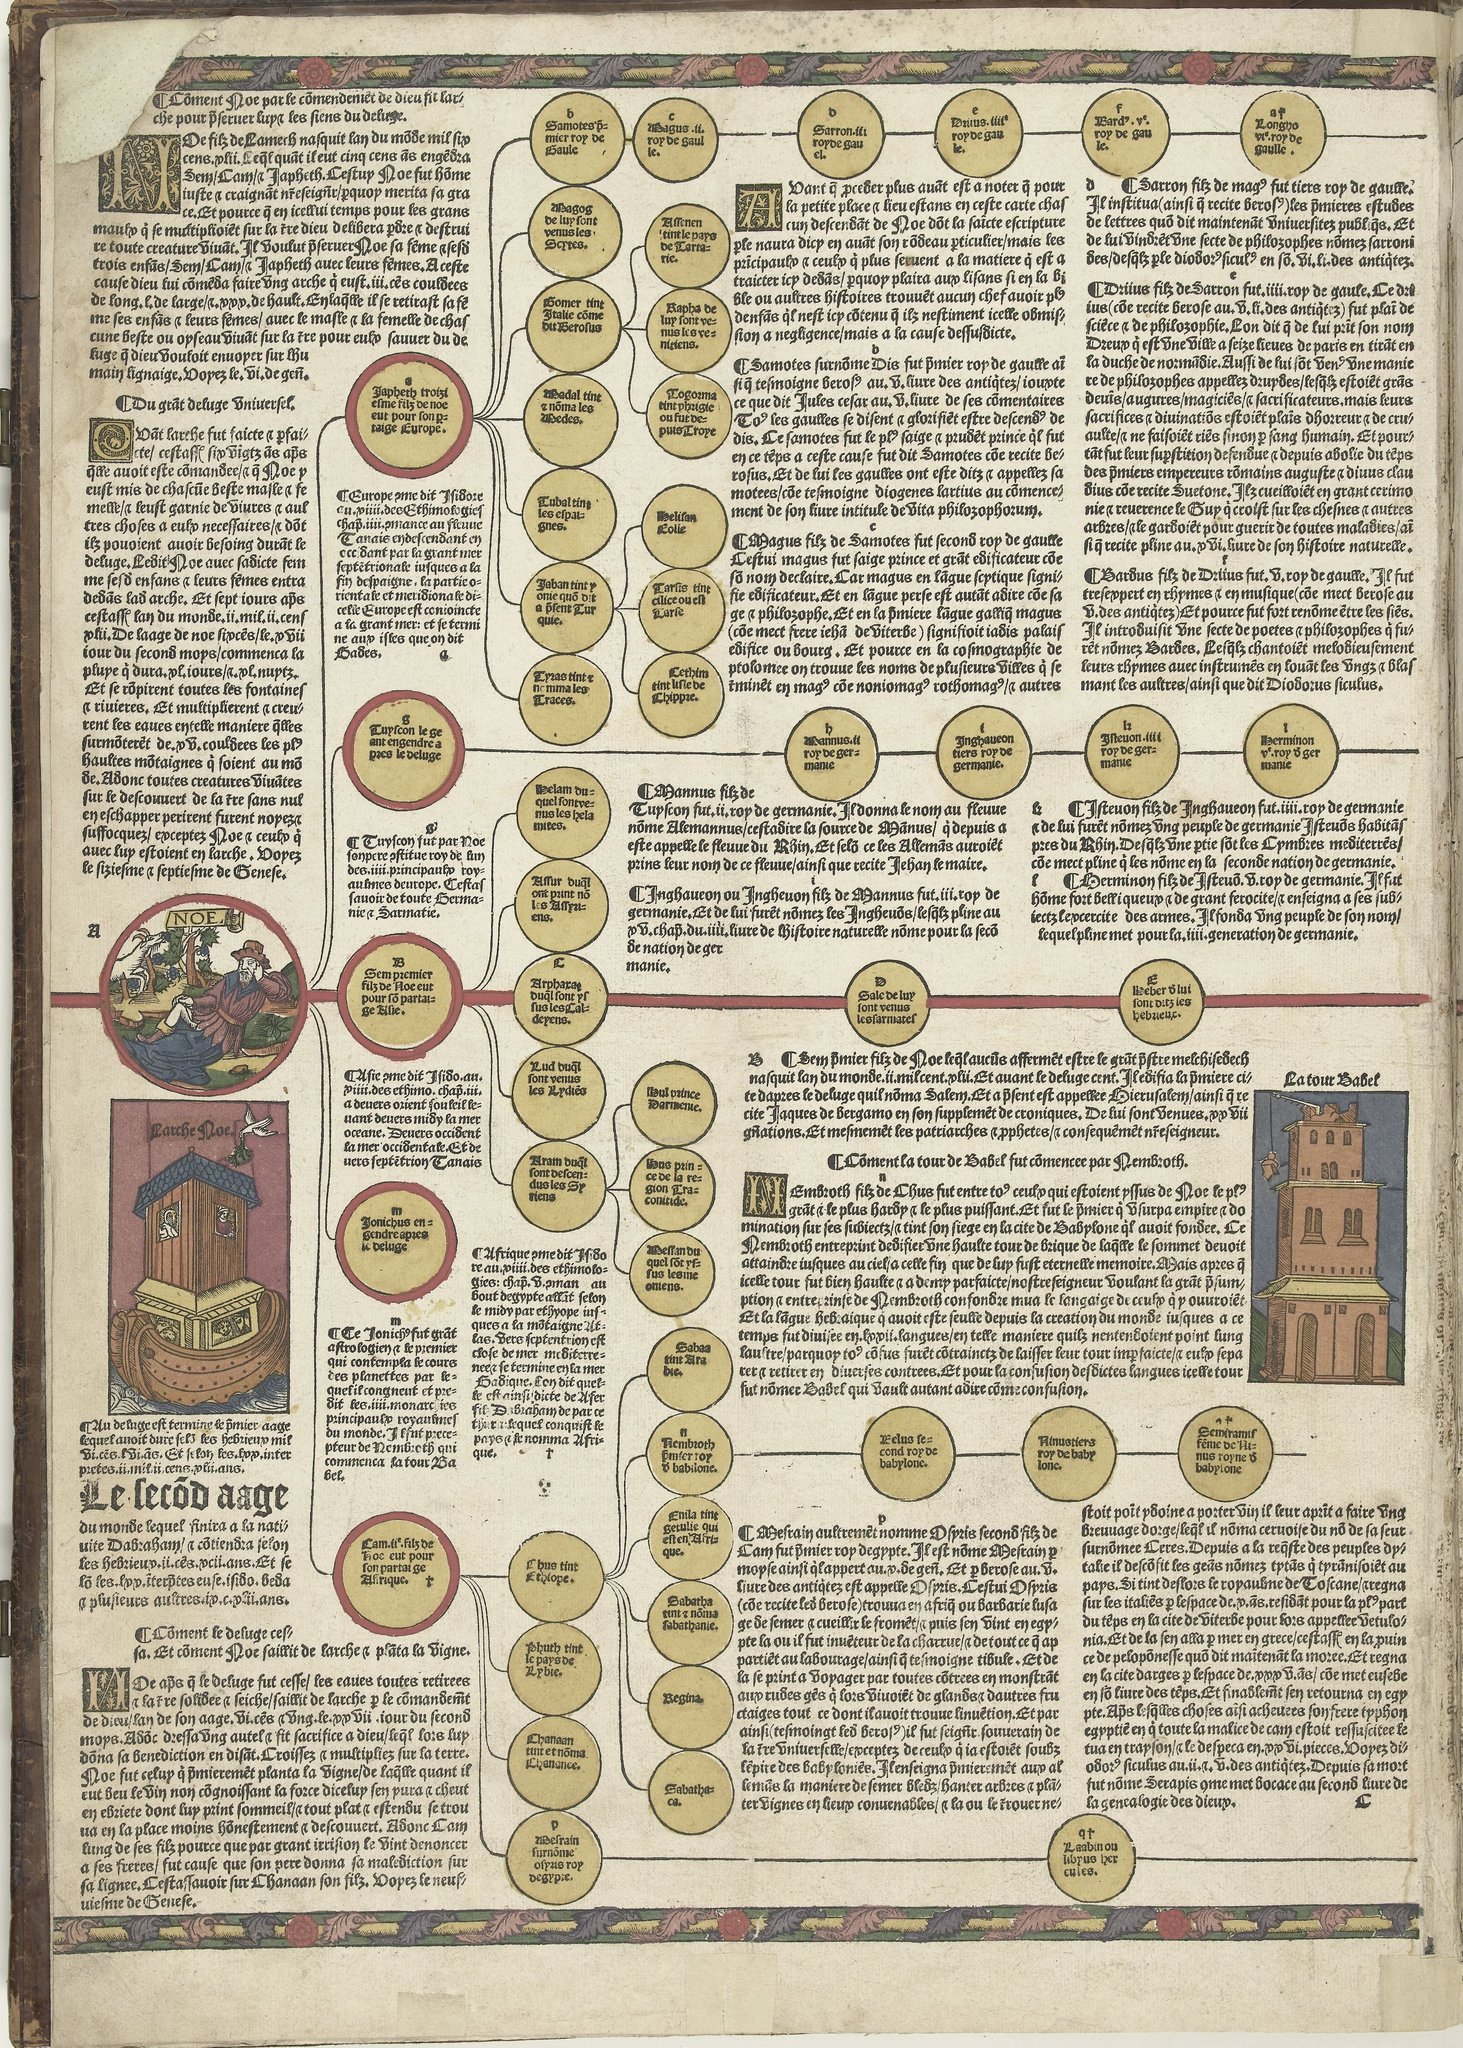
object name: album leaf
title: Cronica Cronicarum (...), blad 2 verso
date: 1521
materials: paper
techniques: letterpress printing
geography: paris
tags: the ark ~ story of noah, the mocking of noah: ham finds his father (partially) naked sleeping out of doors (or in his tent, or in the vineyard cottage); ham calls his brothers (+ variant), the tower of babel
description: Blad 2 verso van een wereldkroniek. Tekst in boekdruk in het Frans imet versierde initialen. Linksonder de titel: Le seco[n]d aage. Links midden een ronde voorstelling van de slapende Noach in zijn wijngaard. Daaronder een voorstelling van de ark van Noach. Rechts een voorstelling van de toren van Babel. Het medaillon met Noach is verbonden met andere cirkels die gevuld zijn met namen: deze vormen samen een schematische weergave van genealogie en vorstenopvolging, vanaf Adam en Eva die zich uitstrekt over meerdere bladzijden van de kroniek.